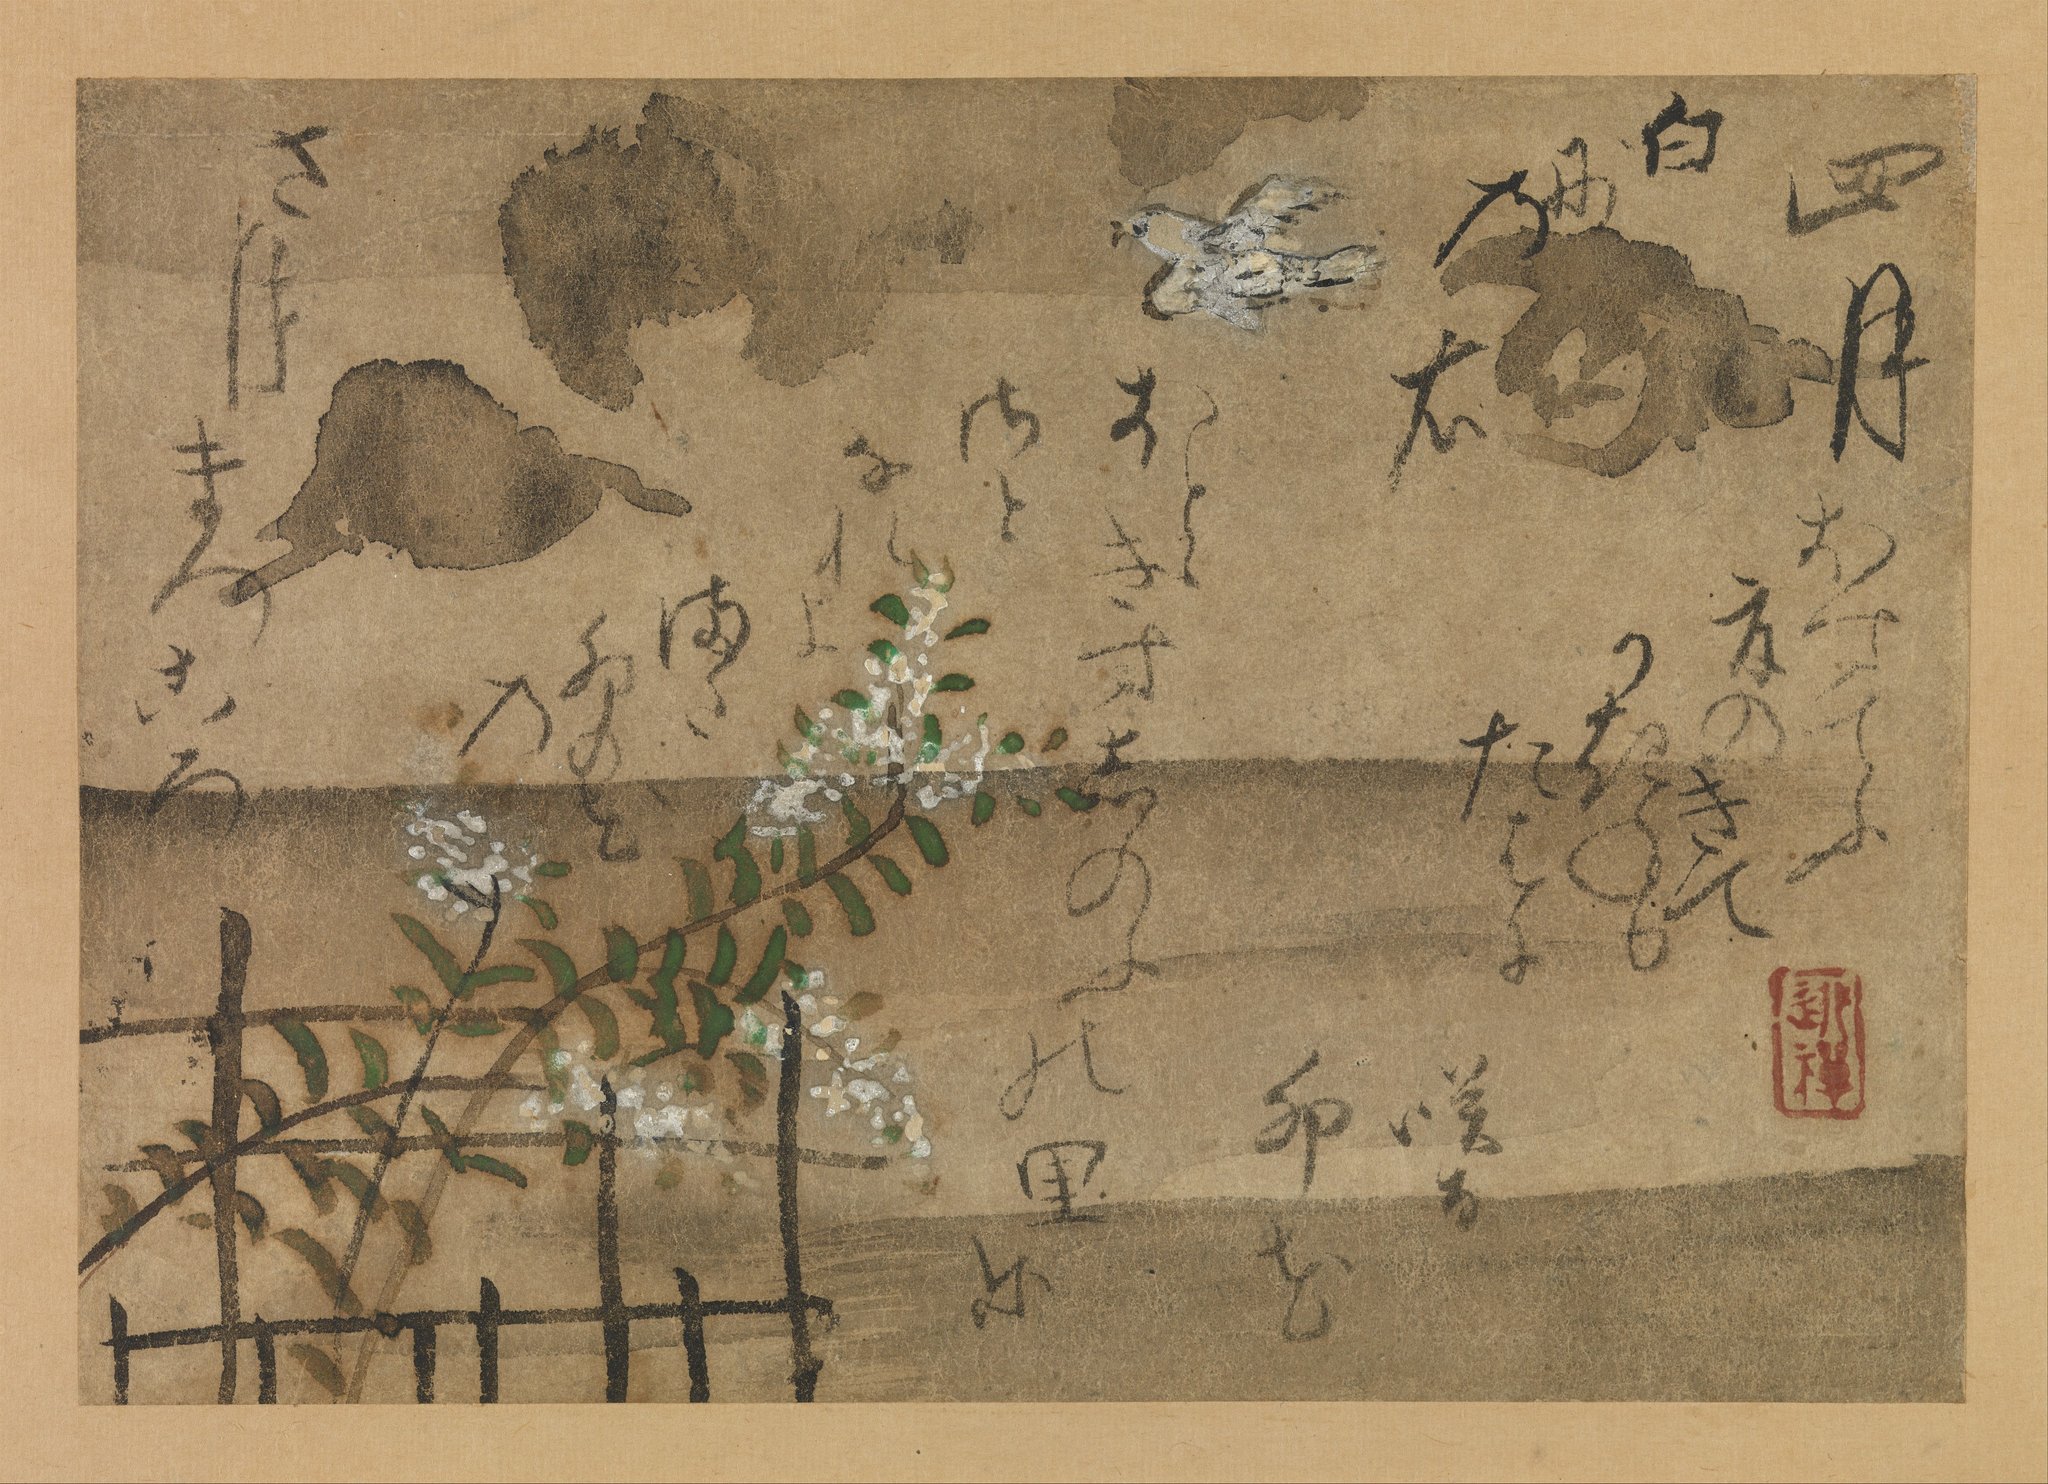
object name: hanging scroll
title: “Fourth Month” from Fujiwara no Teika’s “Birds and Flowers of the Twelve Months”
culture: japanese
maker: ogata kenzan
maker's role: artist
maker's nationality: japanese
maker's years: 1663-1743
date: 1743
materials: ink, paper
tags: birds,flowers